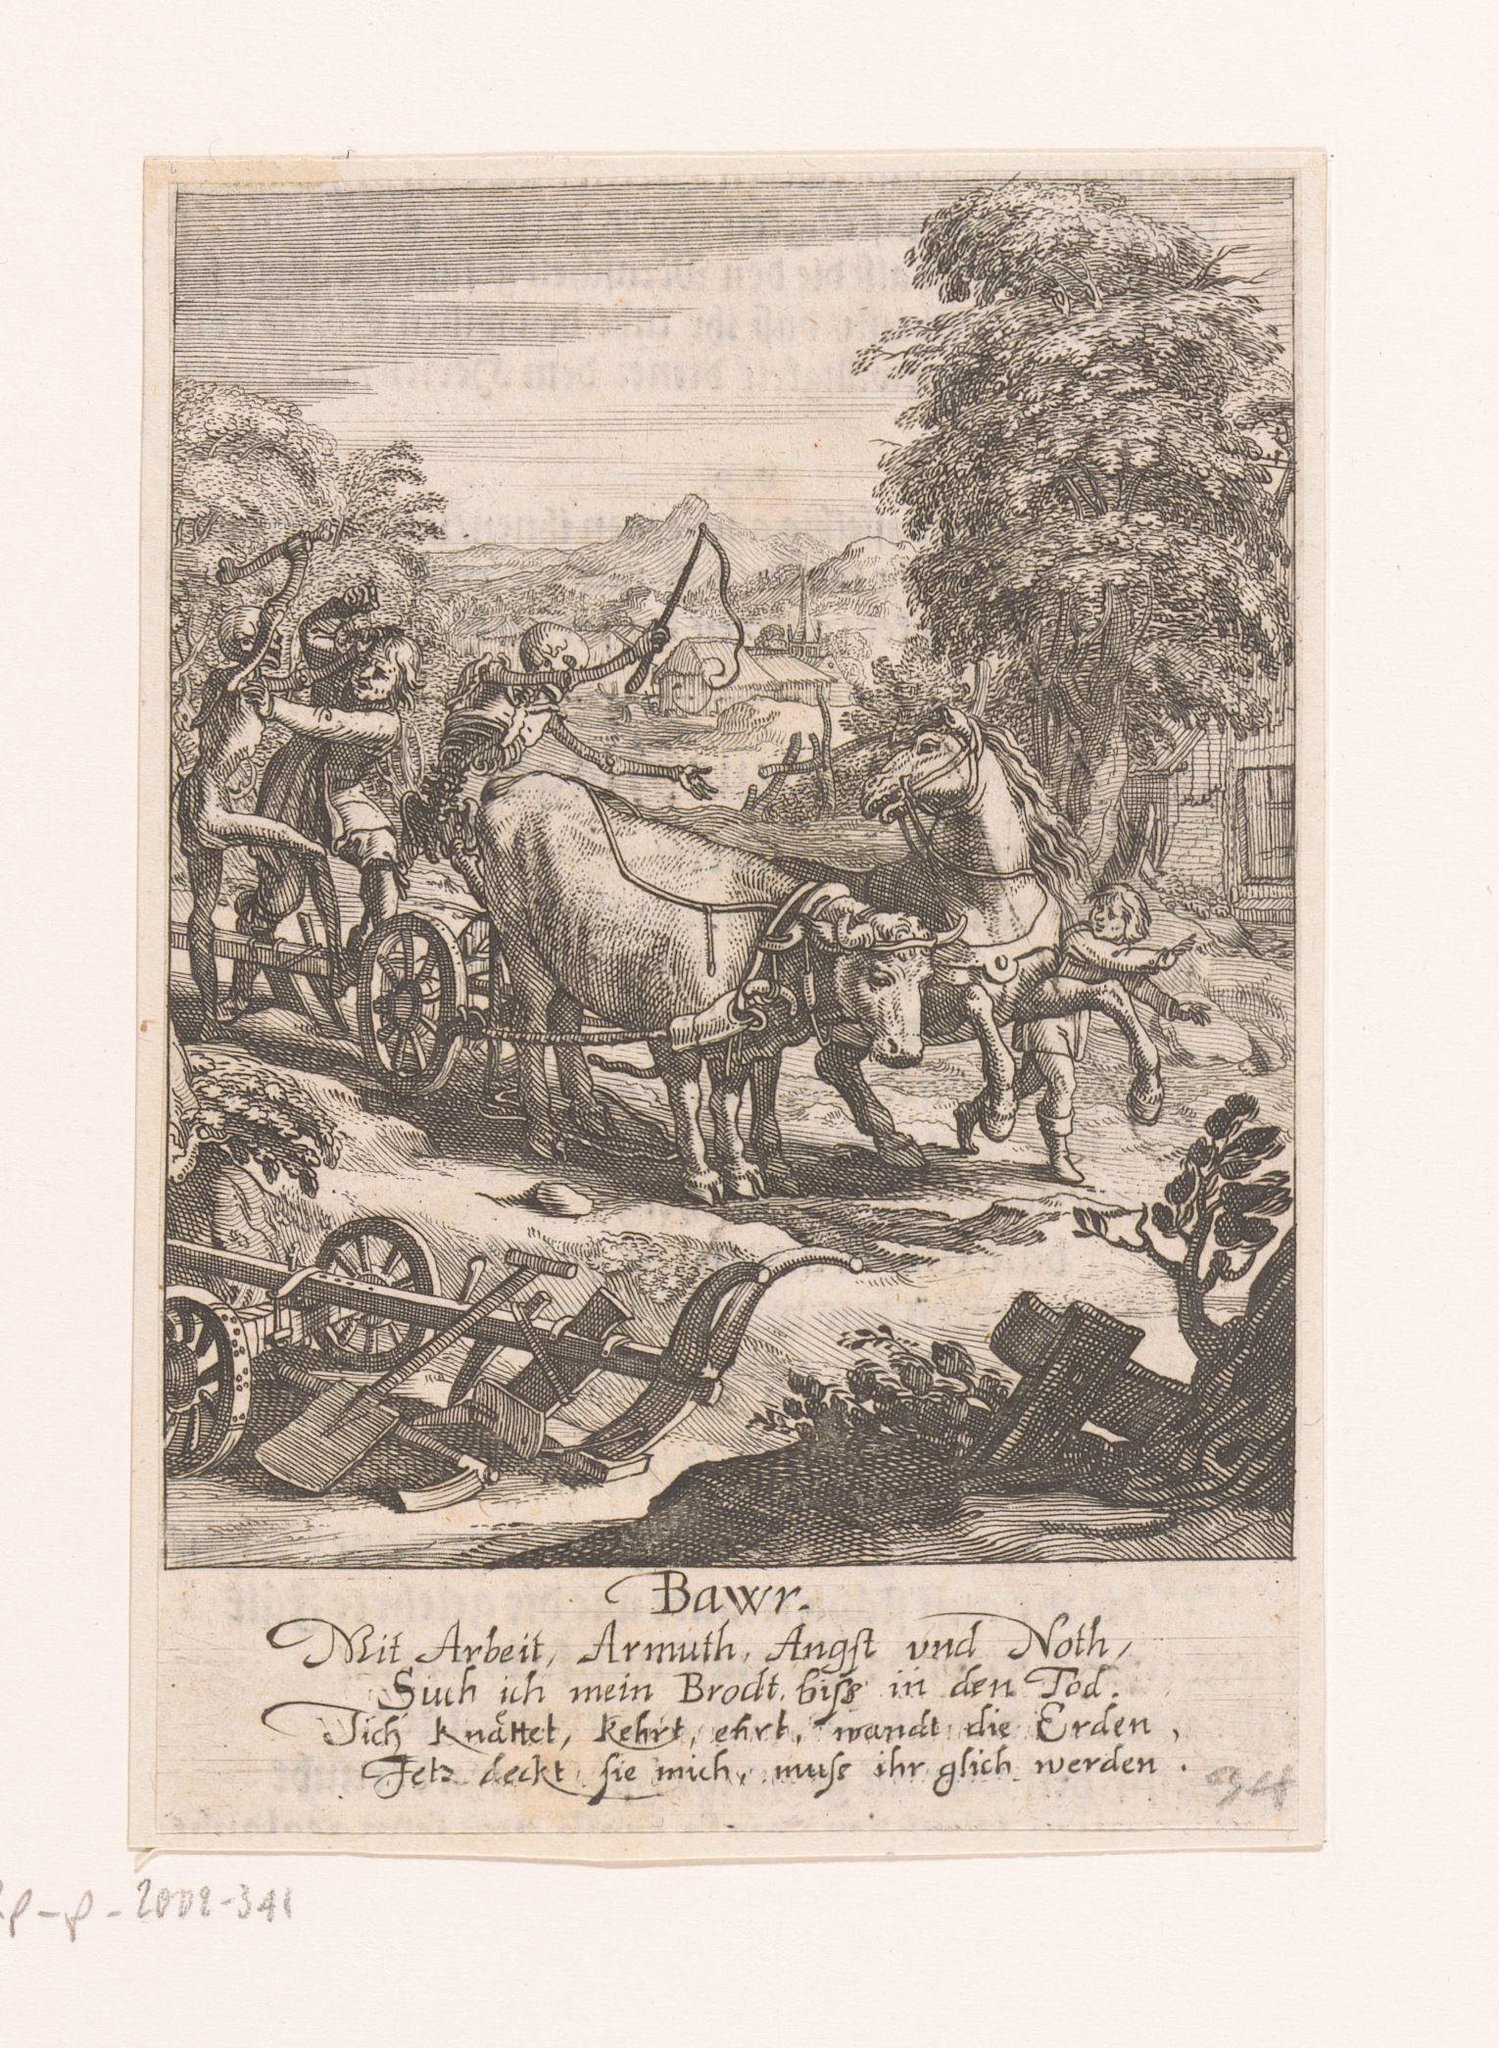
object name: print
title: Boer en de Dood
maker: johann jakob bodmer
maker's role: printer, publisher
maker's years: 1629-1650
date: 1650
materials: paper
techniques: etching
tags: personifications of death; 'morte' (ripa), dance of death; death together with one or more human beings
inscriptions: collector's mark: Lugt 2233, collector's mark: Lugt 2228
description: Prent uit: Meyer, Rudolph. Sterbenspiegel, das ist sonnenklare Vorstellung menschlicher Nichtigkeit durch alle Ständ und Geschlechter (...). Zürich: J.J. Bodmer, 1650.